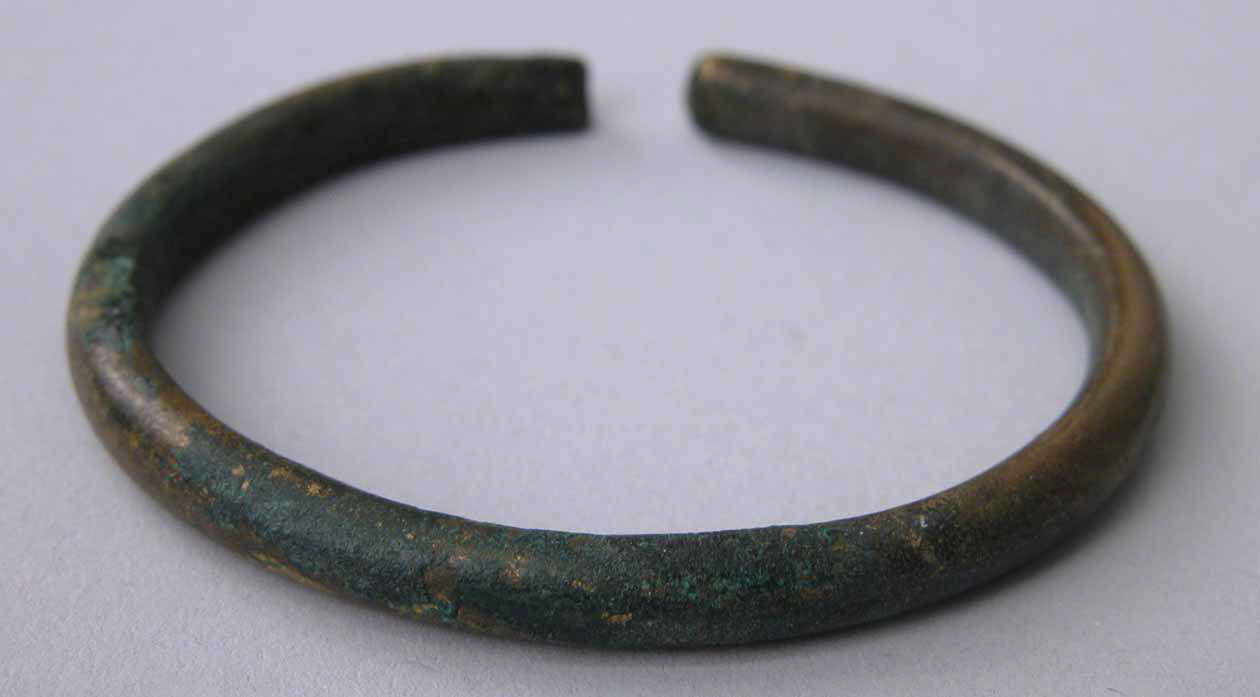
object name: bracelet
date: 201-1200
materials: bronze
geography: egypt